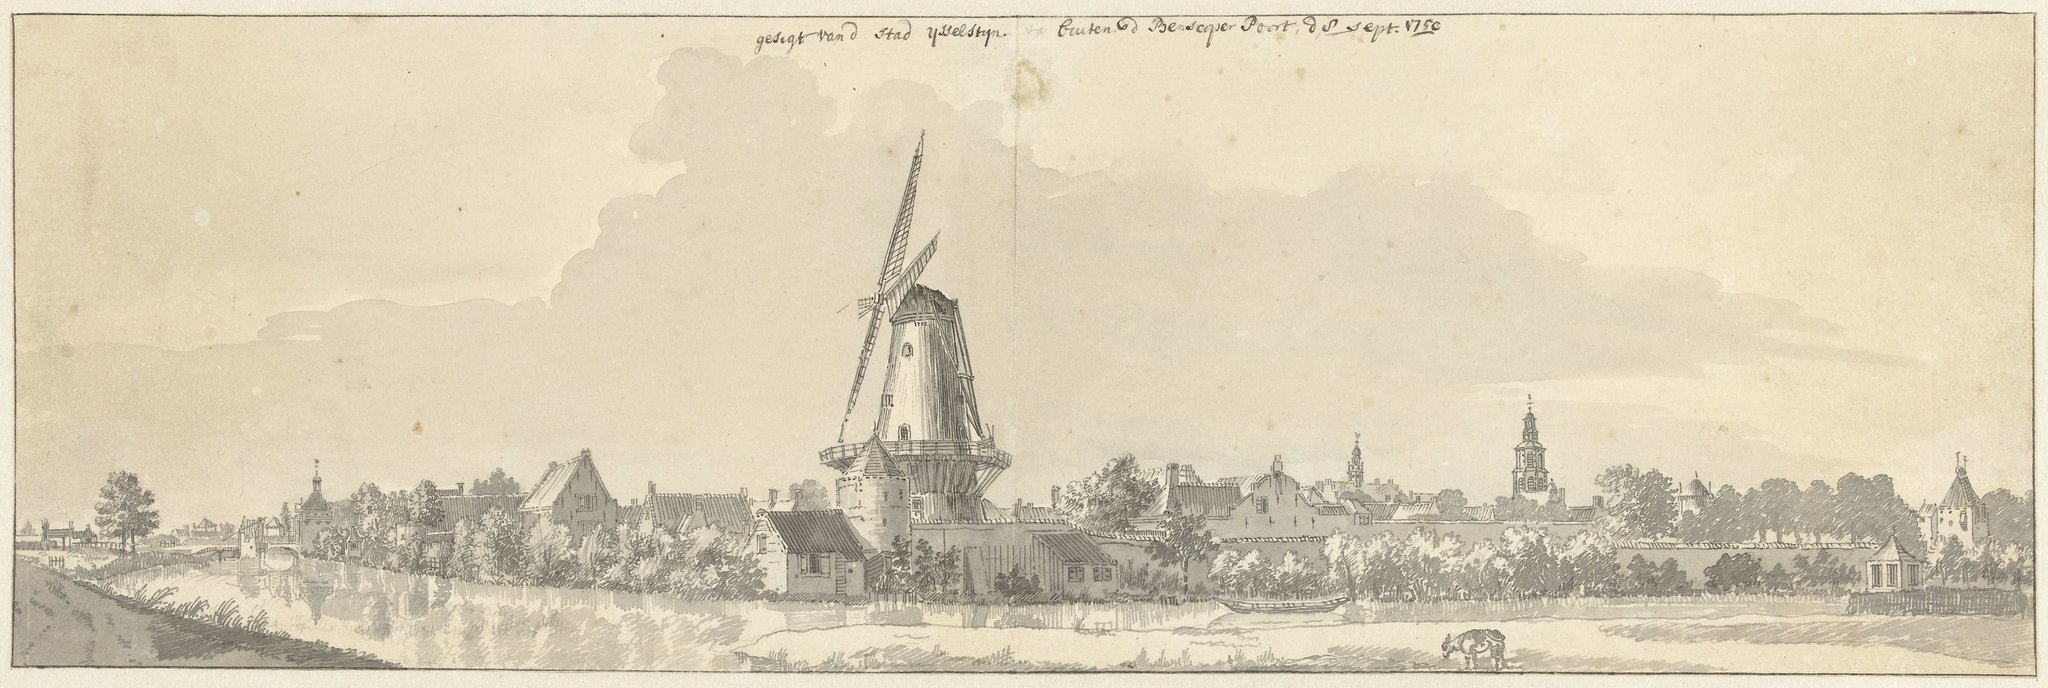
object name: drawing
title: Gezicht op IJsselstein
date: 1750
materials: ink, paper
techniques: brush, pen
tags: prospect of city, town panorama, silhouette of city